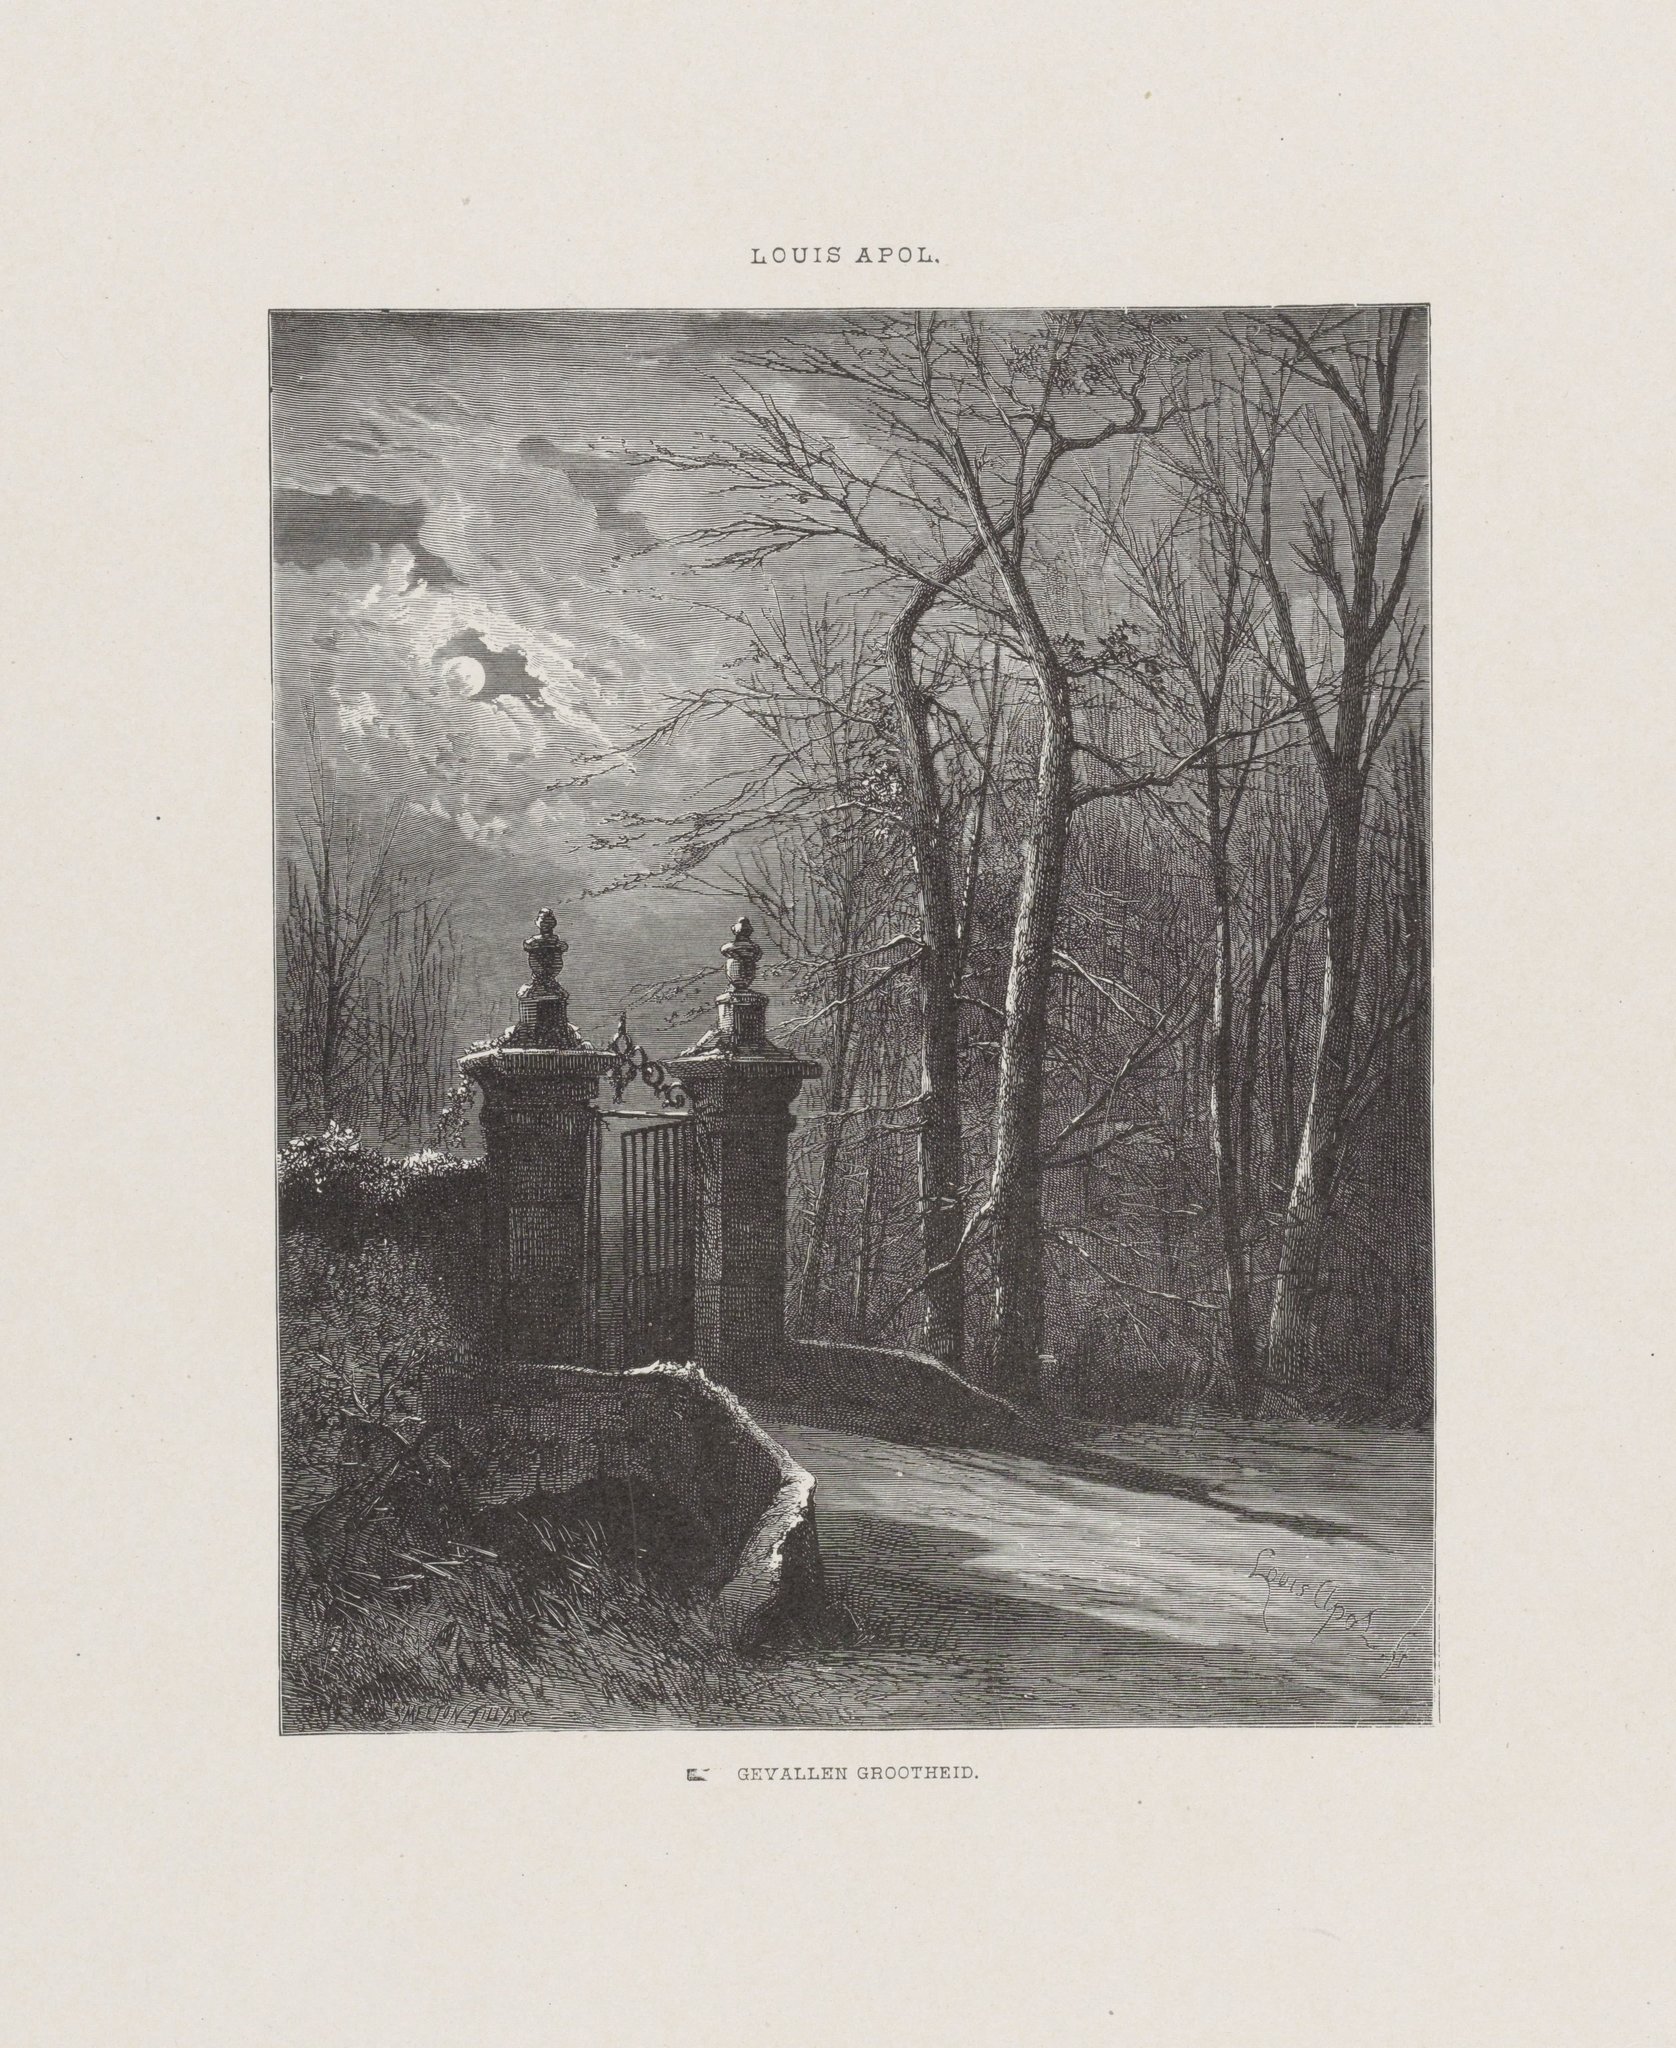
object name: print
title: Gevallen grootheid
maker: louis apol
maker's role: draughtsman, painter, print maker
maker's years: 1850-1936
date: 1874-1888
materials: paper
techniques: engraving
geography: paris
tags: trees, gate, entrance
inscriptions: collector's mark: Lugt 2228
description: Tussen bomen zonder bladeren staat een hek met aan beide zijden stenen pilaren.